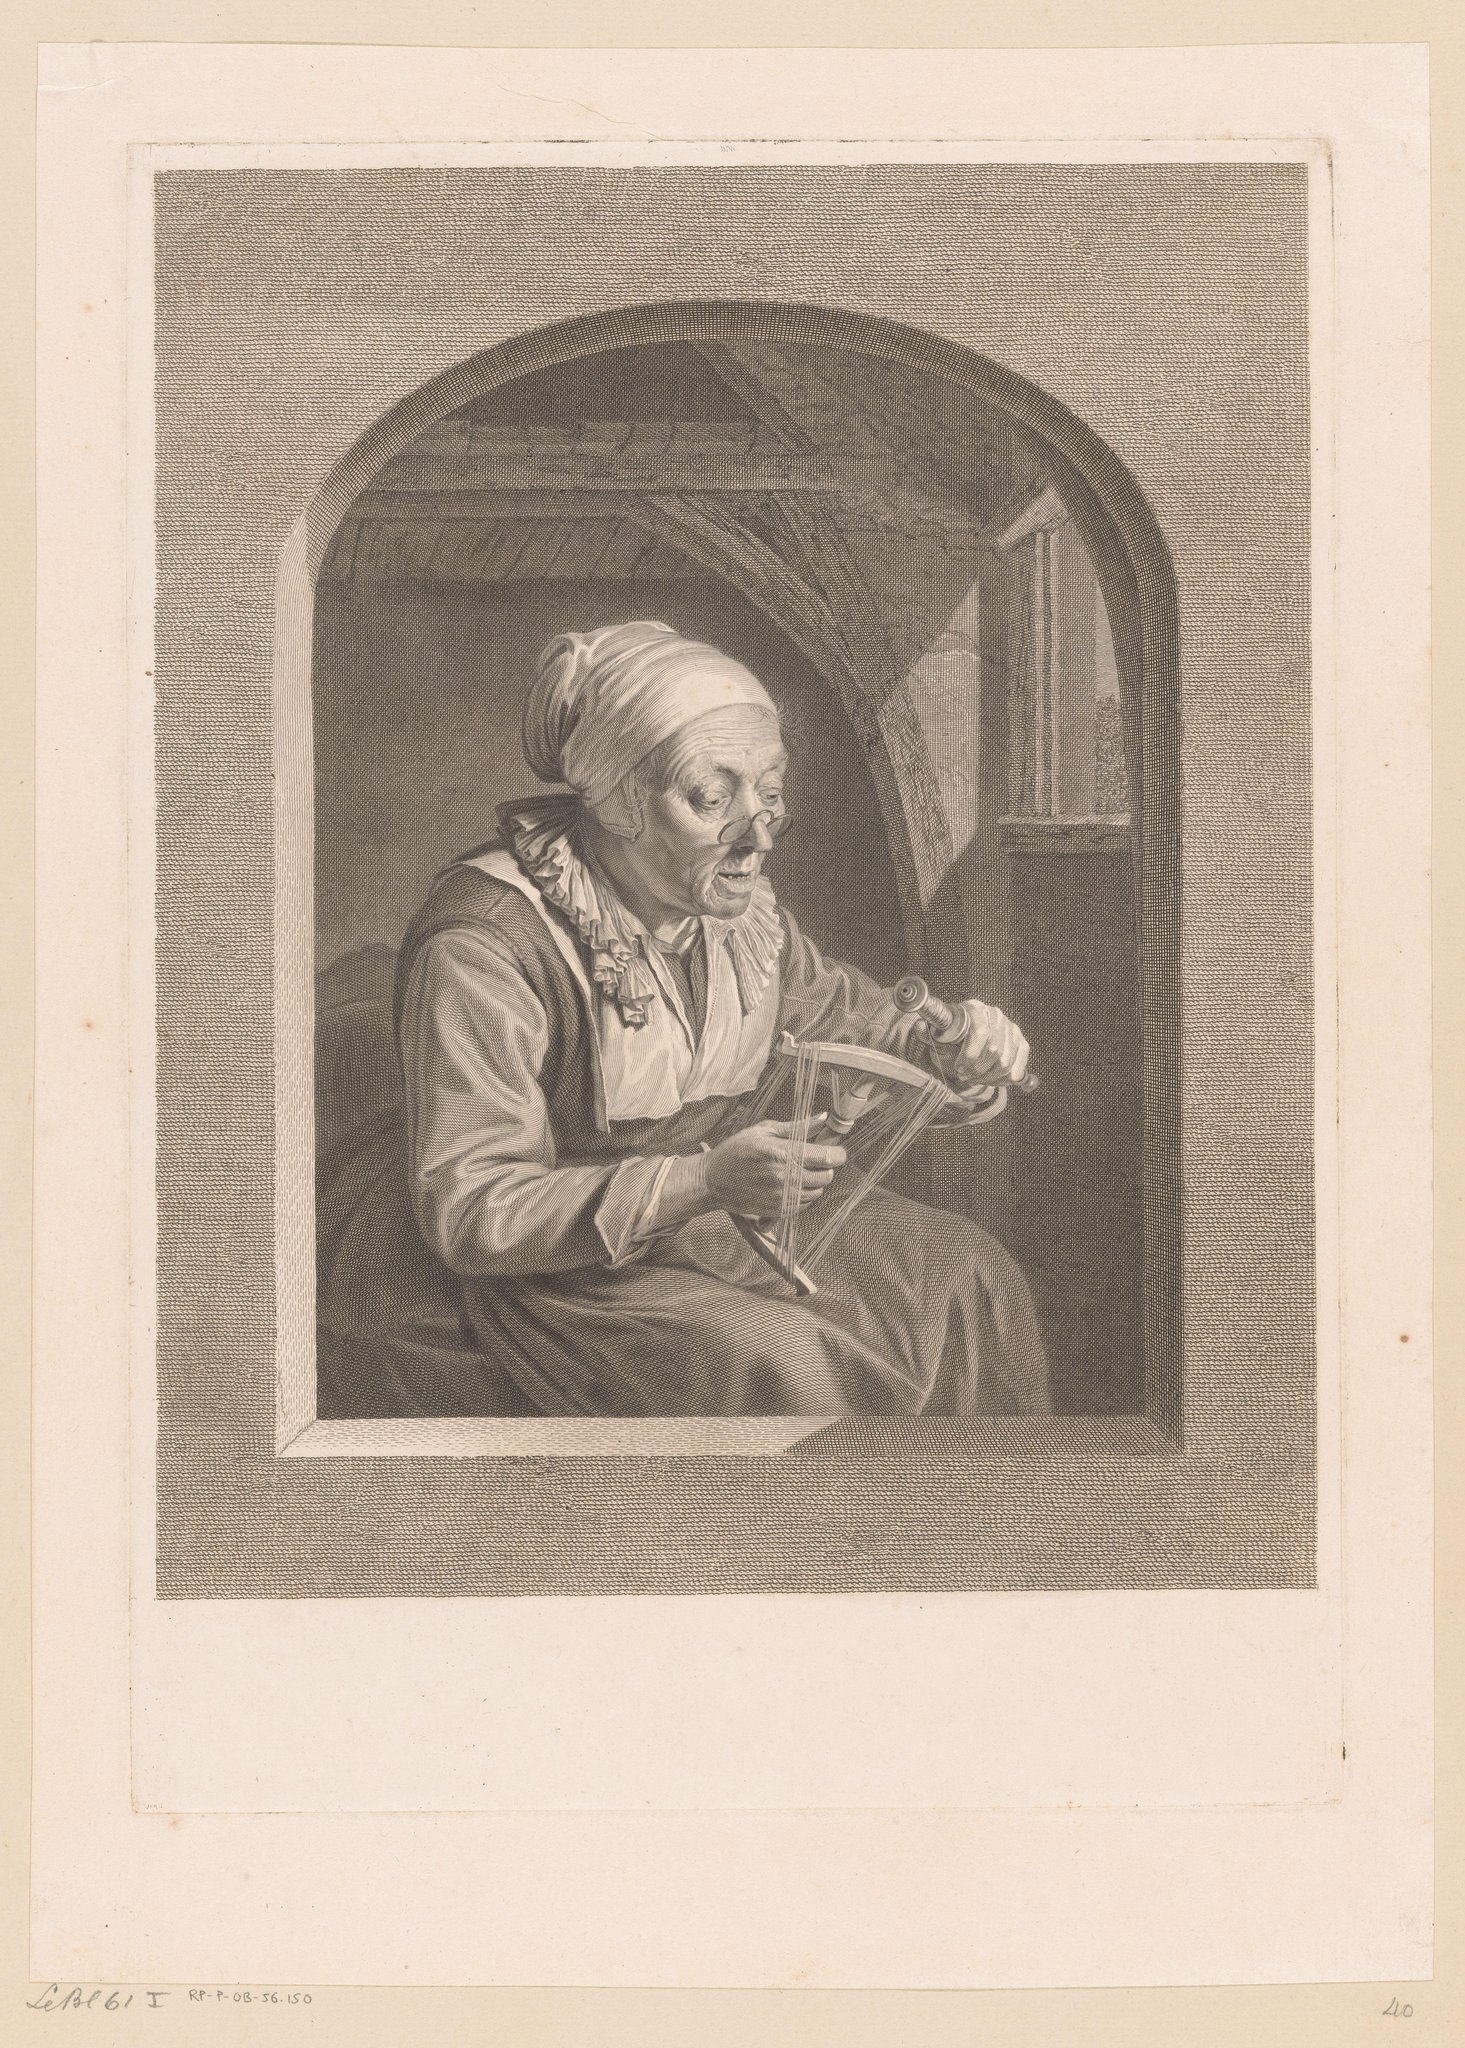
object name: print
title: La devideuse mere de G. Douw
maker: johann georg wille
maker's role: draughtsman, print maker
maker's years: 1715-1808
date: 1755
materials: paper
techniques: engraving, etching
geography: paris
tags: eyeglasses, spectacles, old woman, winding of yarn on reels or spools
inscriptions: collector's mark: Lugt 240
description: Deze prent maakt deel uit van een serie van onbekende omvang naar Nederlandse en Duitse schilderijen. Op sommige prenten staat linksboven aangegeven welk nummer in de serie het betreft.